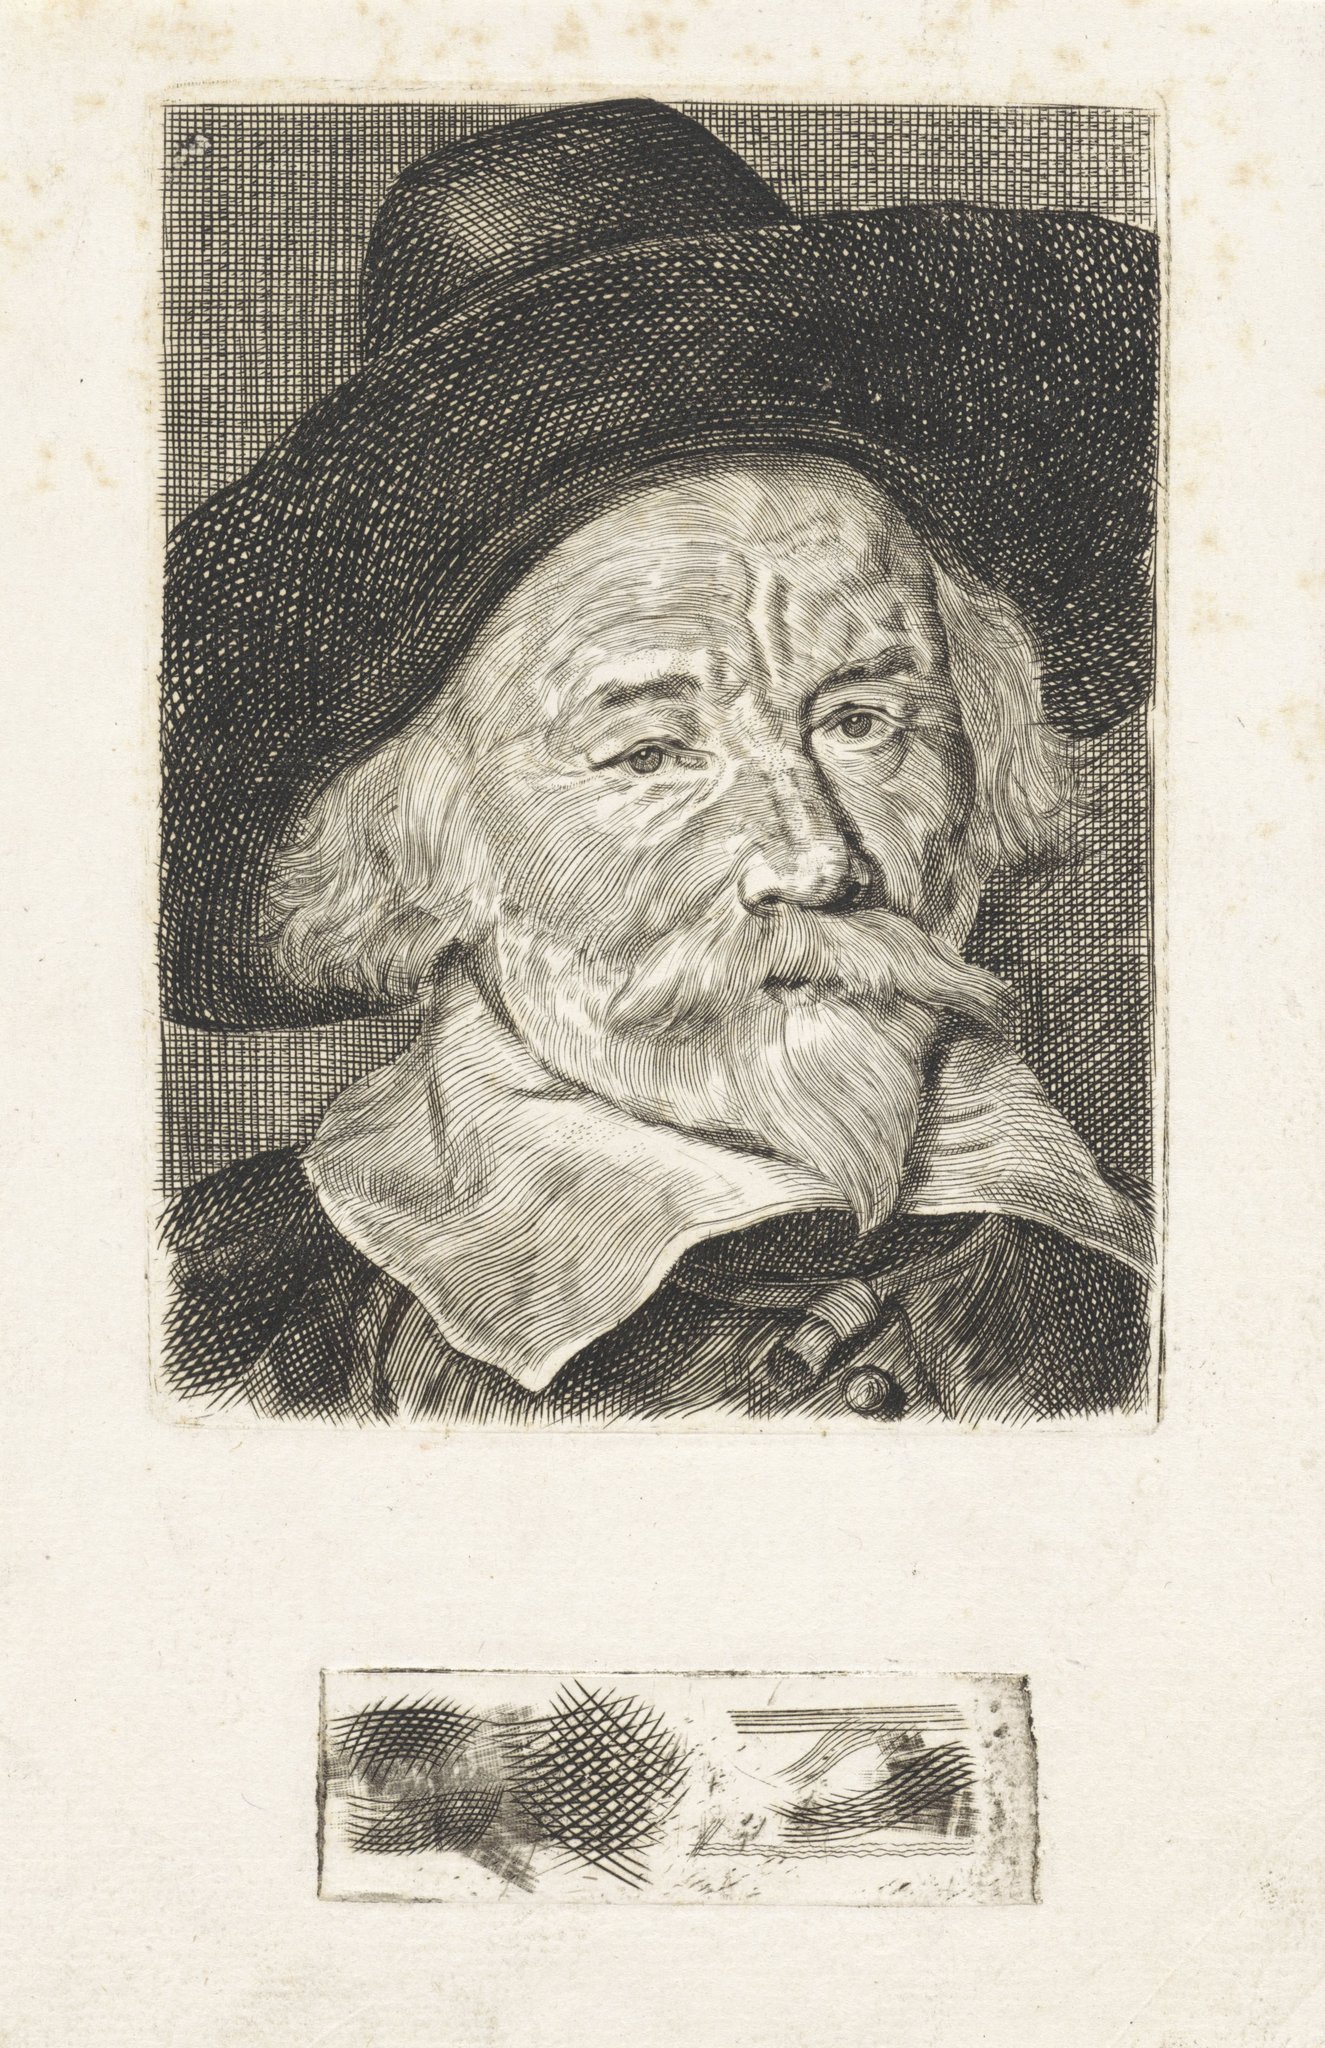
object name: print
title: Portret van Petrus Scriverius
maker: nicolaas van der worm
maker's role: draughtsman, print maker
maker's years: 1757-1828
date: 1772-1816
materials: paper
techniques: engraving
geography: leiden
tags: petrus scriverius, head-gear: hat (+ men's clothes)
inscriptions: collector's mark: Lugt 240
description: Buste van een oude, bebaarde man met een hoed. Daaronder een studieblad met enkele lijnen en arceringen.